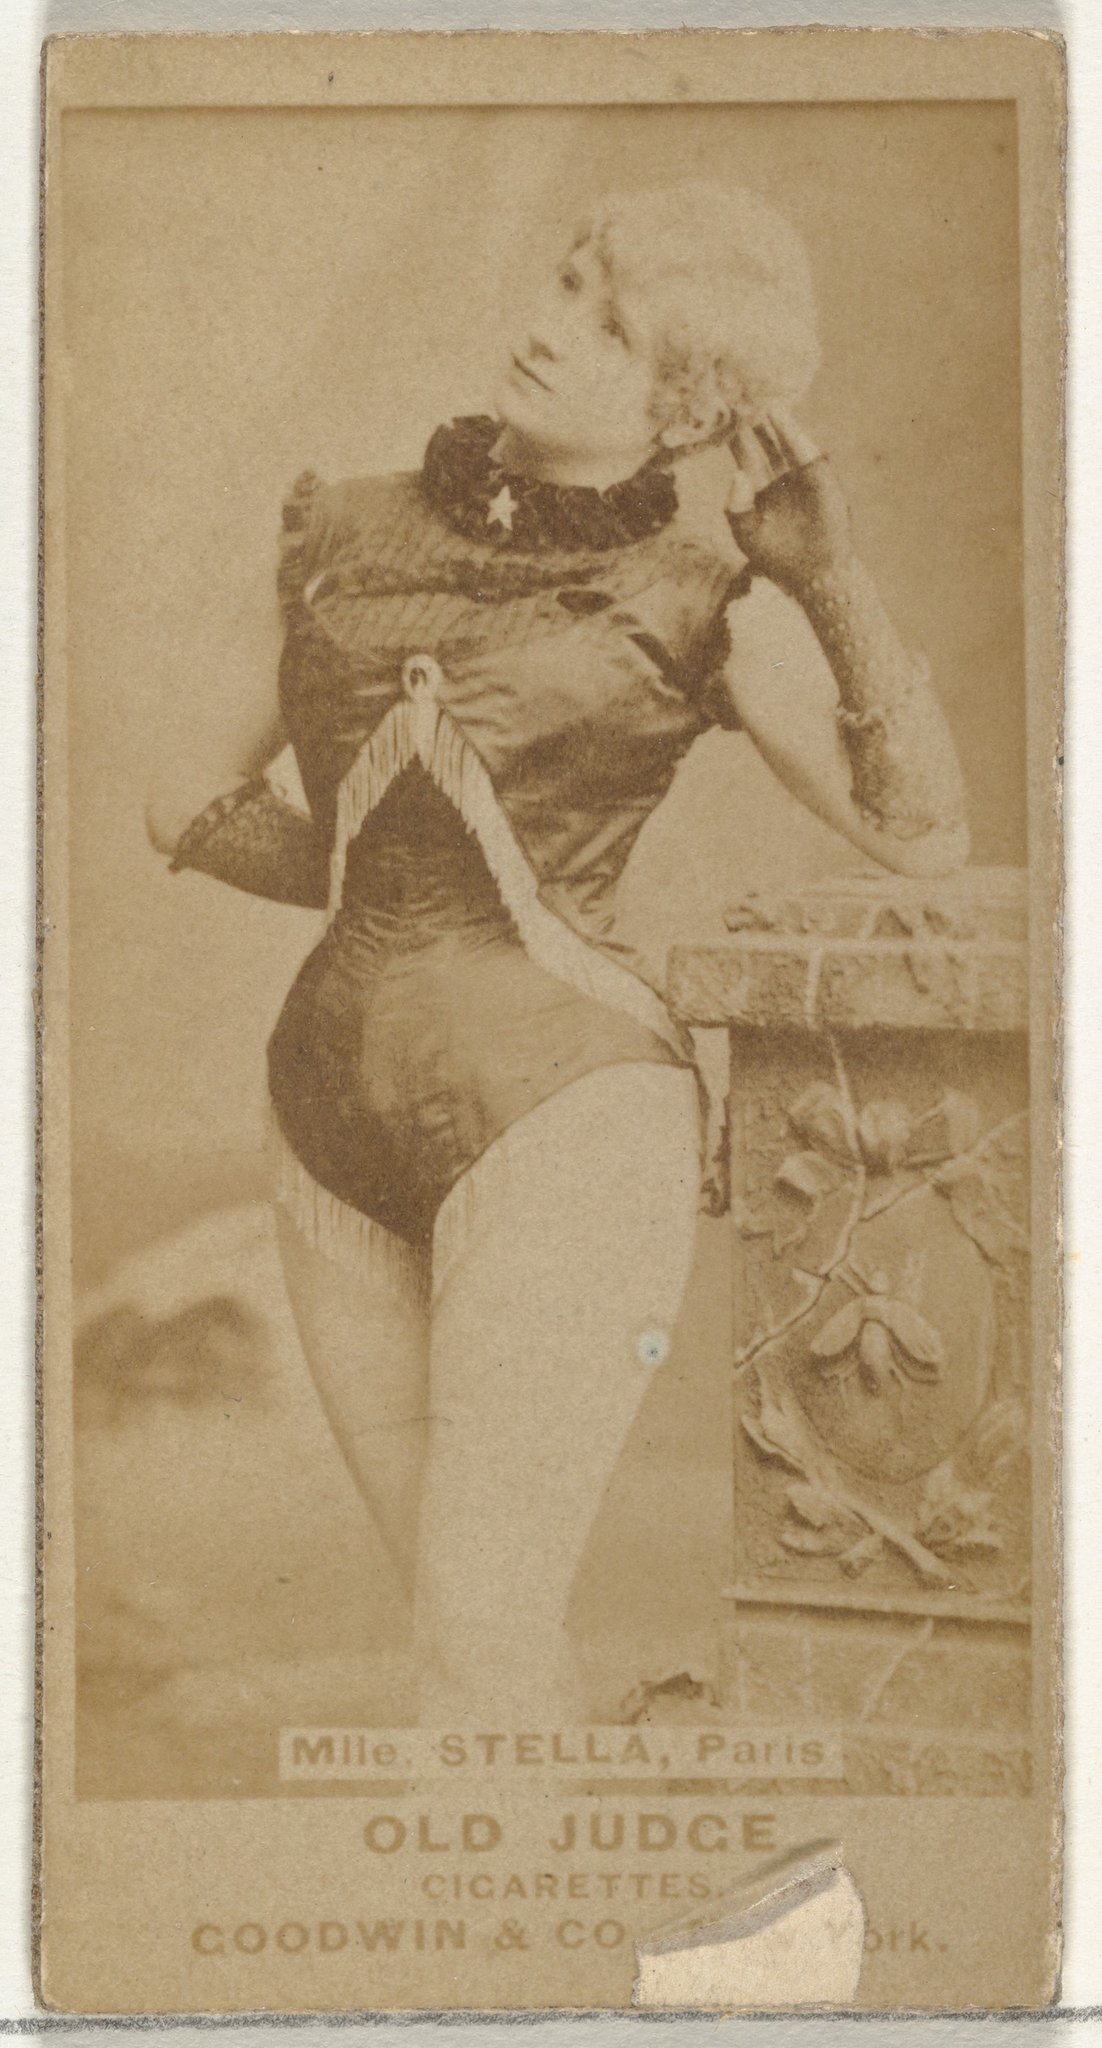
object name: photograph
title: Mlle. Stella, Paris, from the Actors and Actresses series (N171) for Old Judge Cigarettes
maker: goodwin & company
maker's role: publisher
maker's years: 1850-1950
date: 1886-1890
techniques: albumen silver print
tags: portraits,women,actresses